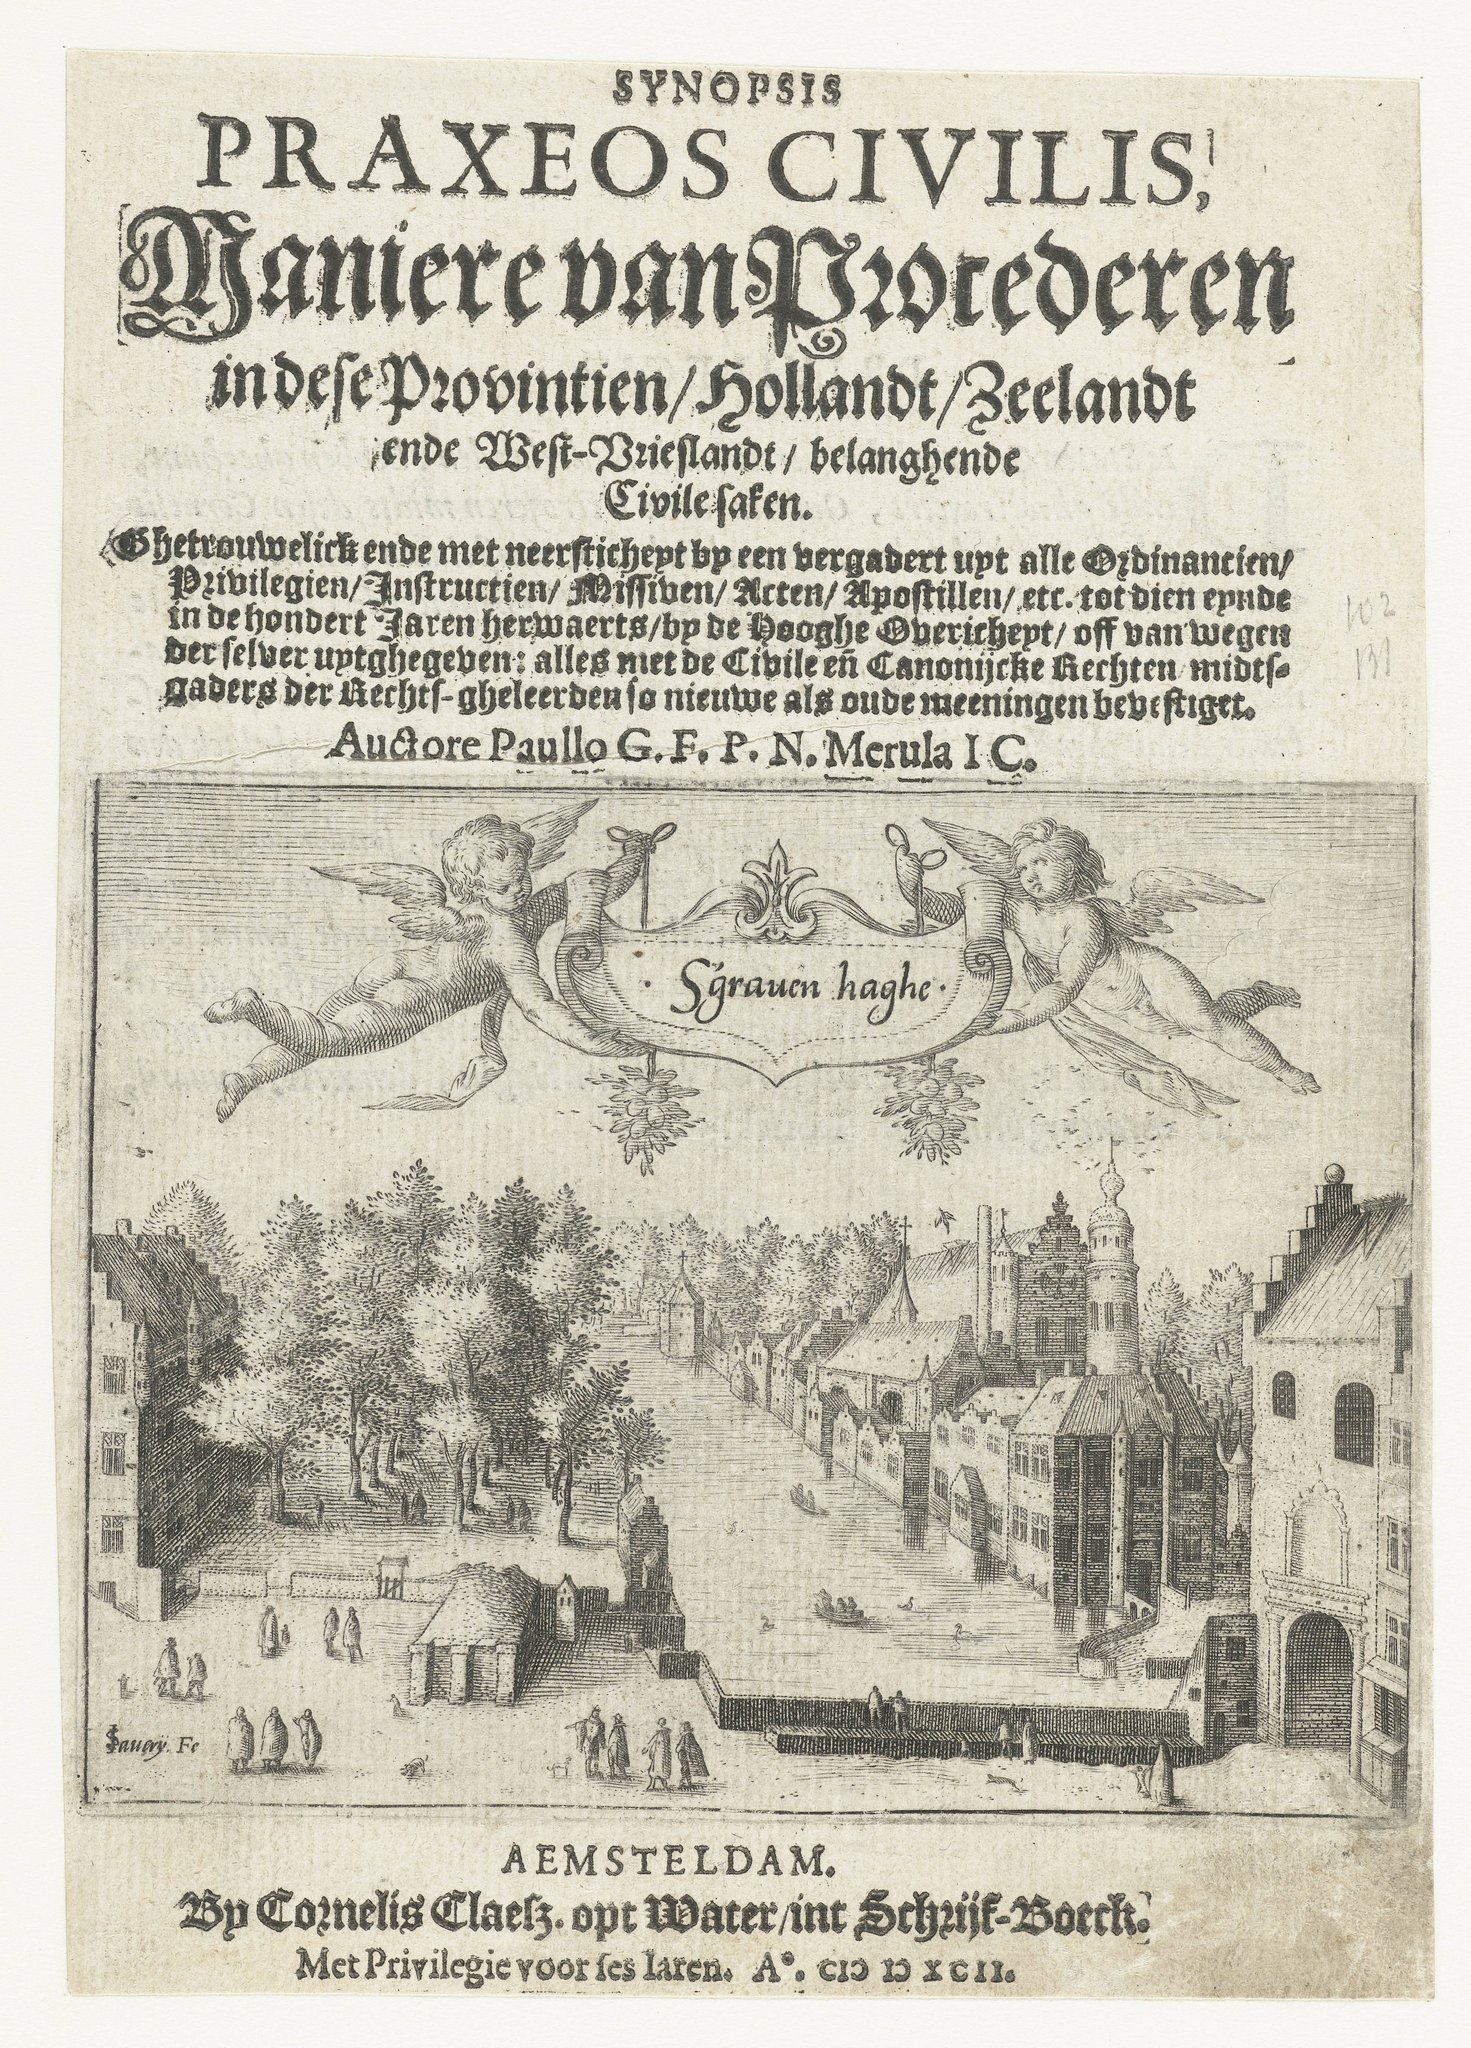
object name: print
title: Titelblad van 'Maniere van Procederen' met een gezicht op de Vijverberg en het Binnenhof te Den Haag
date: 1592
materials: paper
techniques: engraving, etching, letterpress printing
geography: amsterdam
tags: city-view in general; 'veduta', national government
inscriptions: collector's mark: Lugt 2228a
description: Titelblad van een juridische uitgave met een voorstelling van de Vijverberg en het Binnenhof te Den Haag. In de lucht boven Den Haag zijn twee engeltjes weergegeven die een cartouche vasthouden waarop 'S'graven haghe' staat. Boven de prent de titelgegevens, onder de prent het adres van de uitgever. Op de achterzijde van het blad de tekst van een privilegeverlening aan uitgever Claesz.